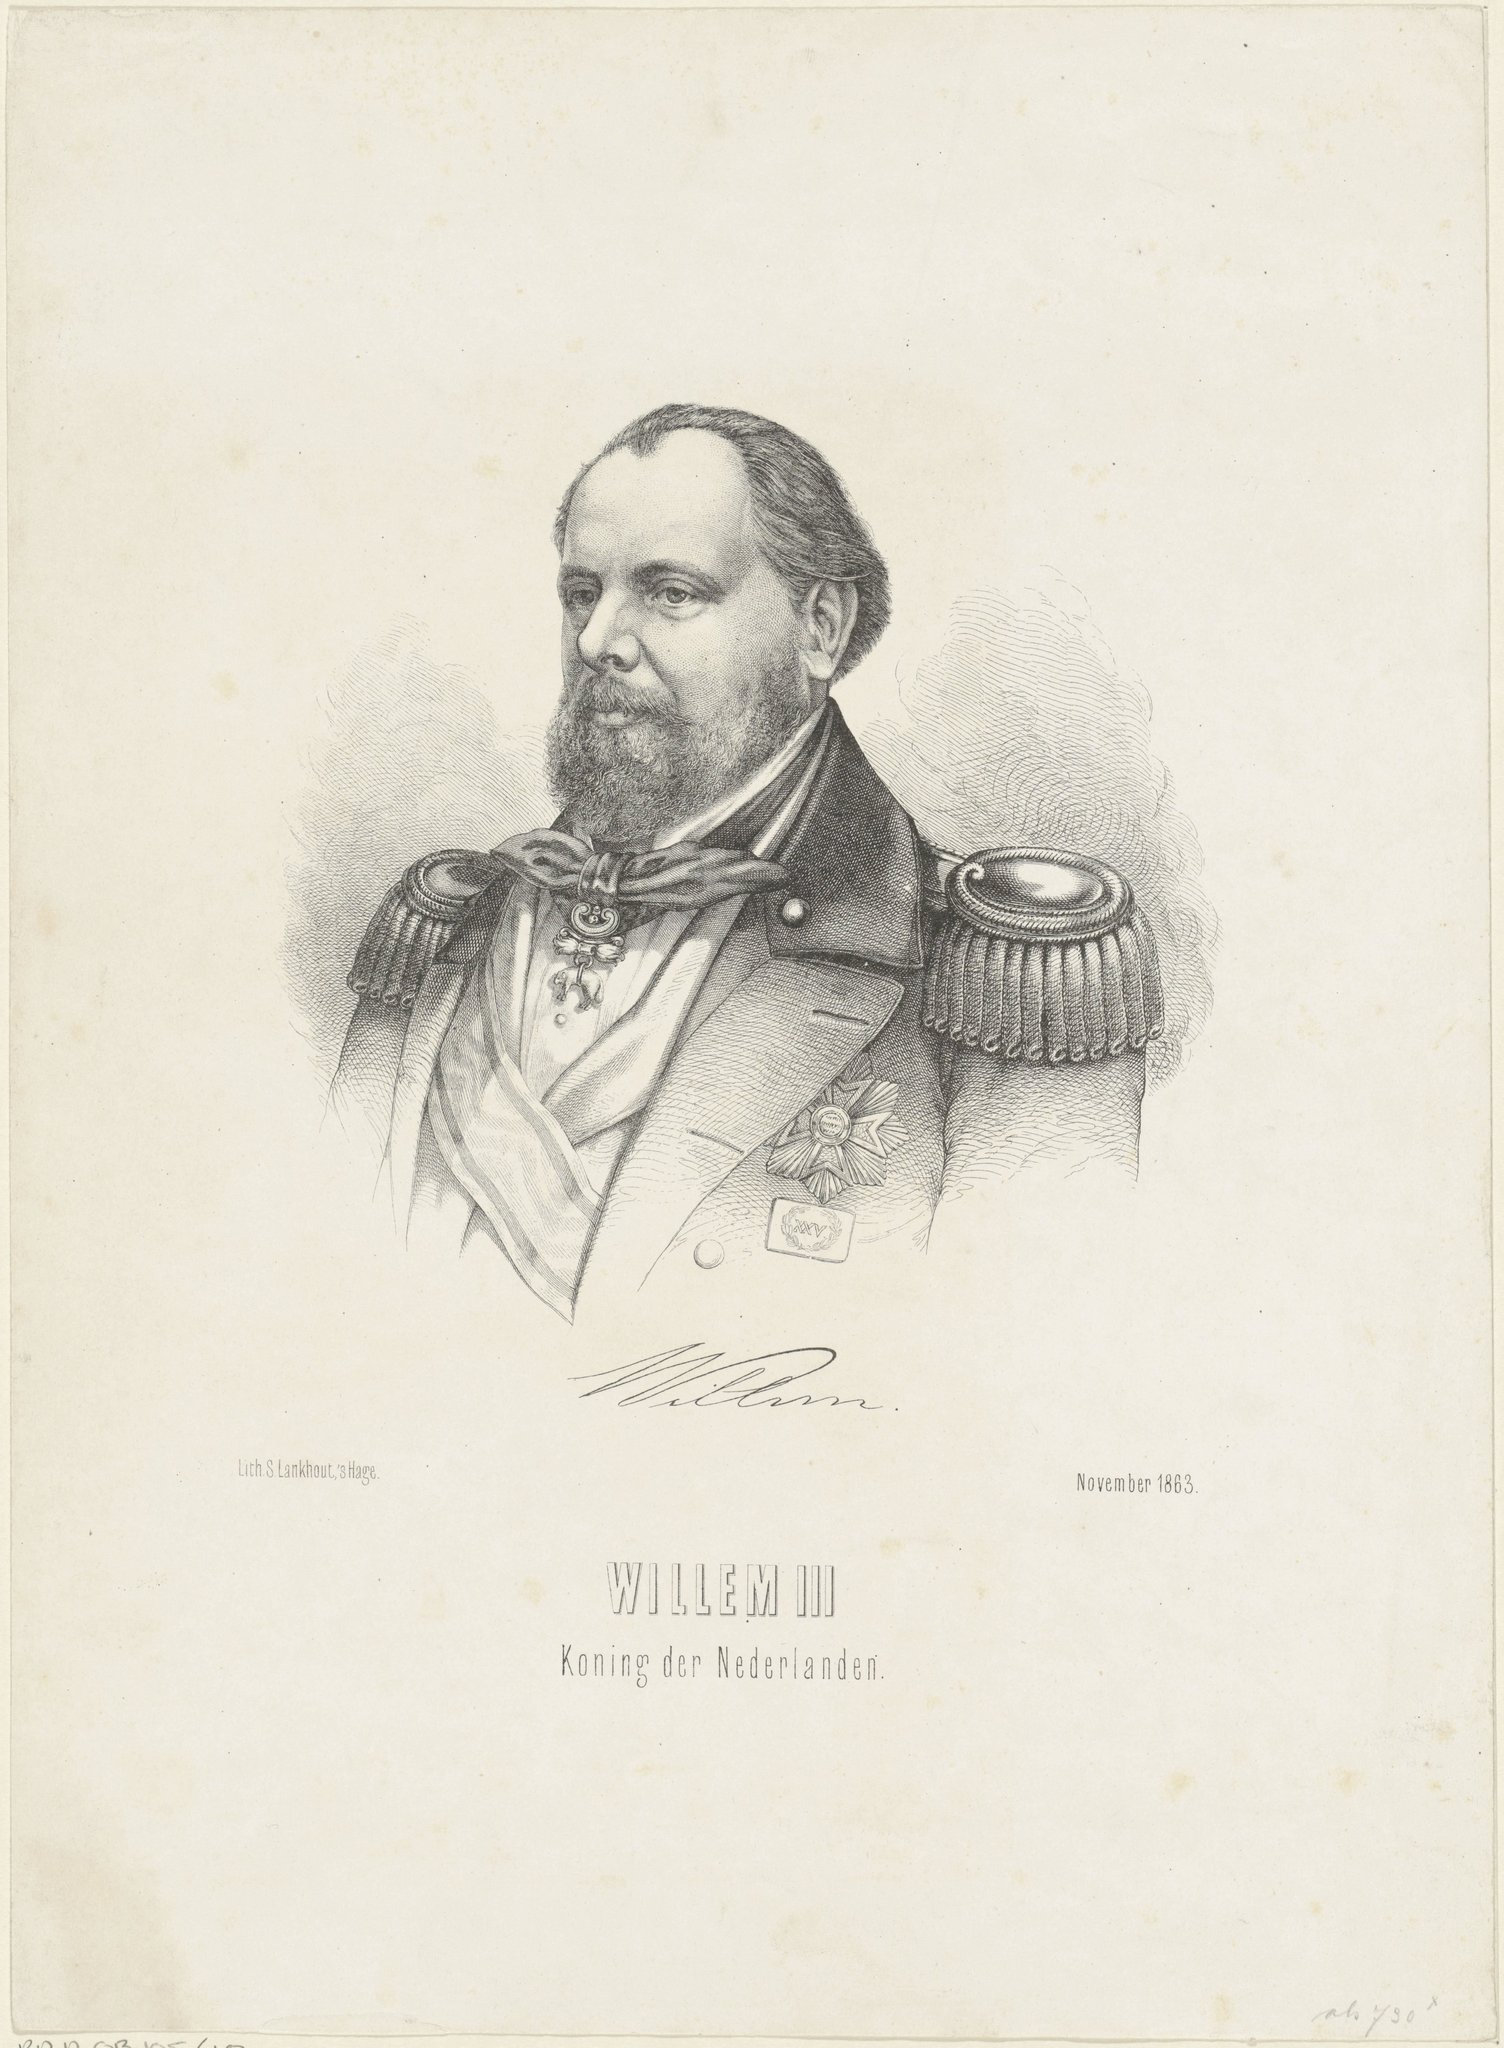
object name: print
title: Portret van Willem III, koning der Nederlanden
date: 1811-1863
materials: paper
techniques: engraving, etching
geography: netherlands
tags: willem iii (koning der nederlanden), knighthood order of the golden fleece - insignia of a knighthood order, e.g.: badge, chain (with name of order)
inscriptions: date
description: De hier vermelde titel verwijst naar de hoogst verkregen titel van de geportretteerde, niet per se naar de titel die de geportretteerde op deze voorstelling draagt.